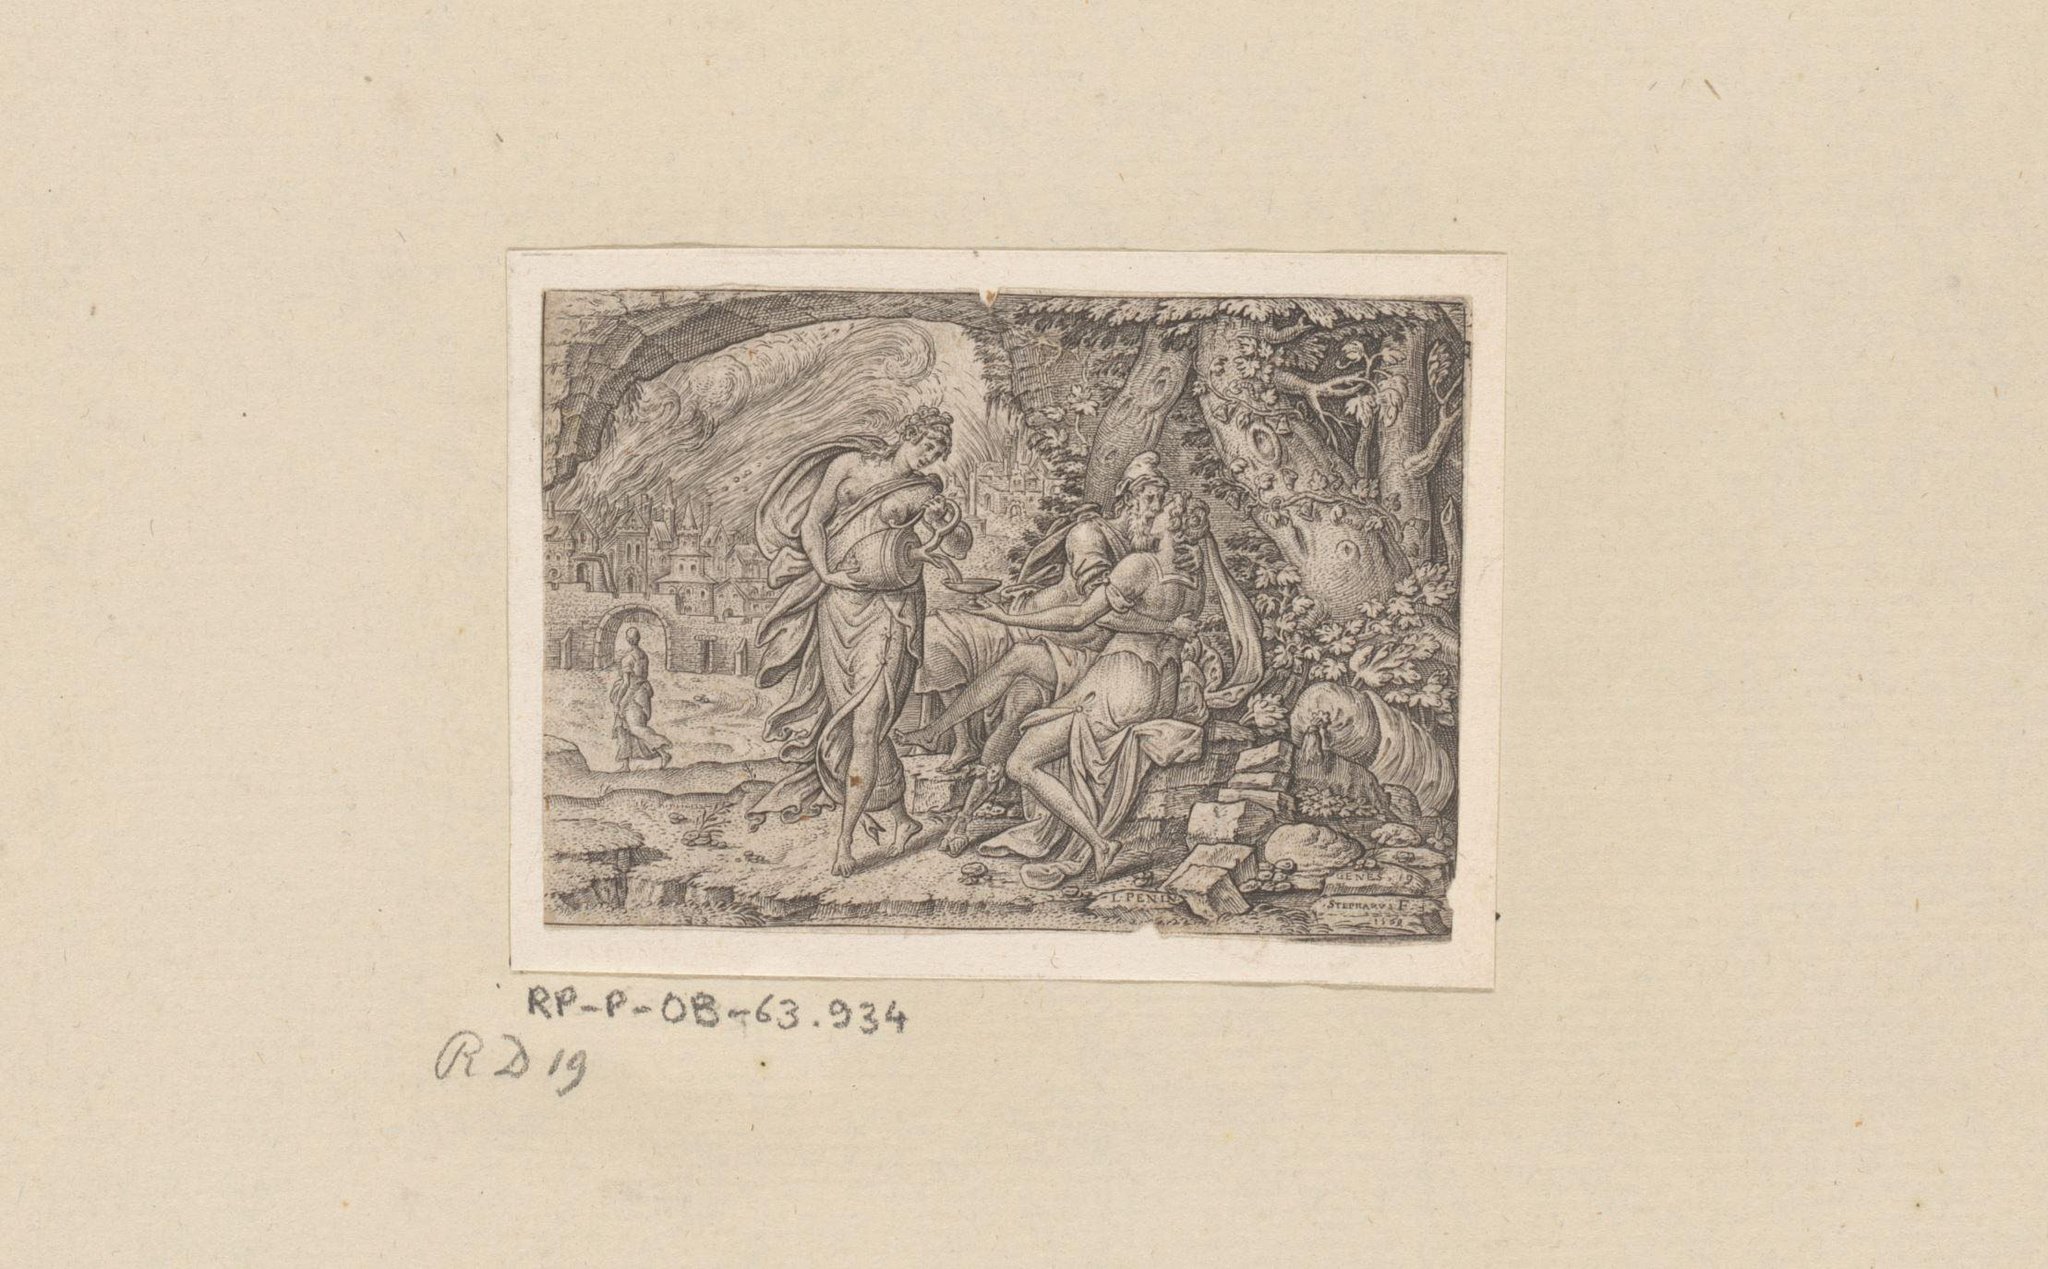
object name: print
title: Lot dronken gevoerd door zijn dochters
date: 1569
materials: paper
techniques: engraving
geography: france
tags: lot's daughters make their father drunk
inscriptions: collector's mark: Lugt 240